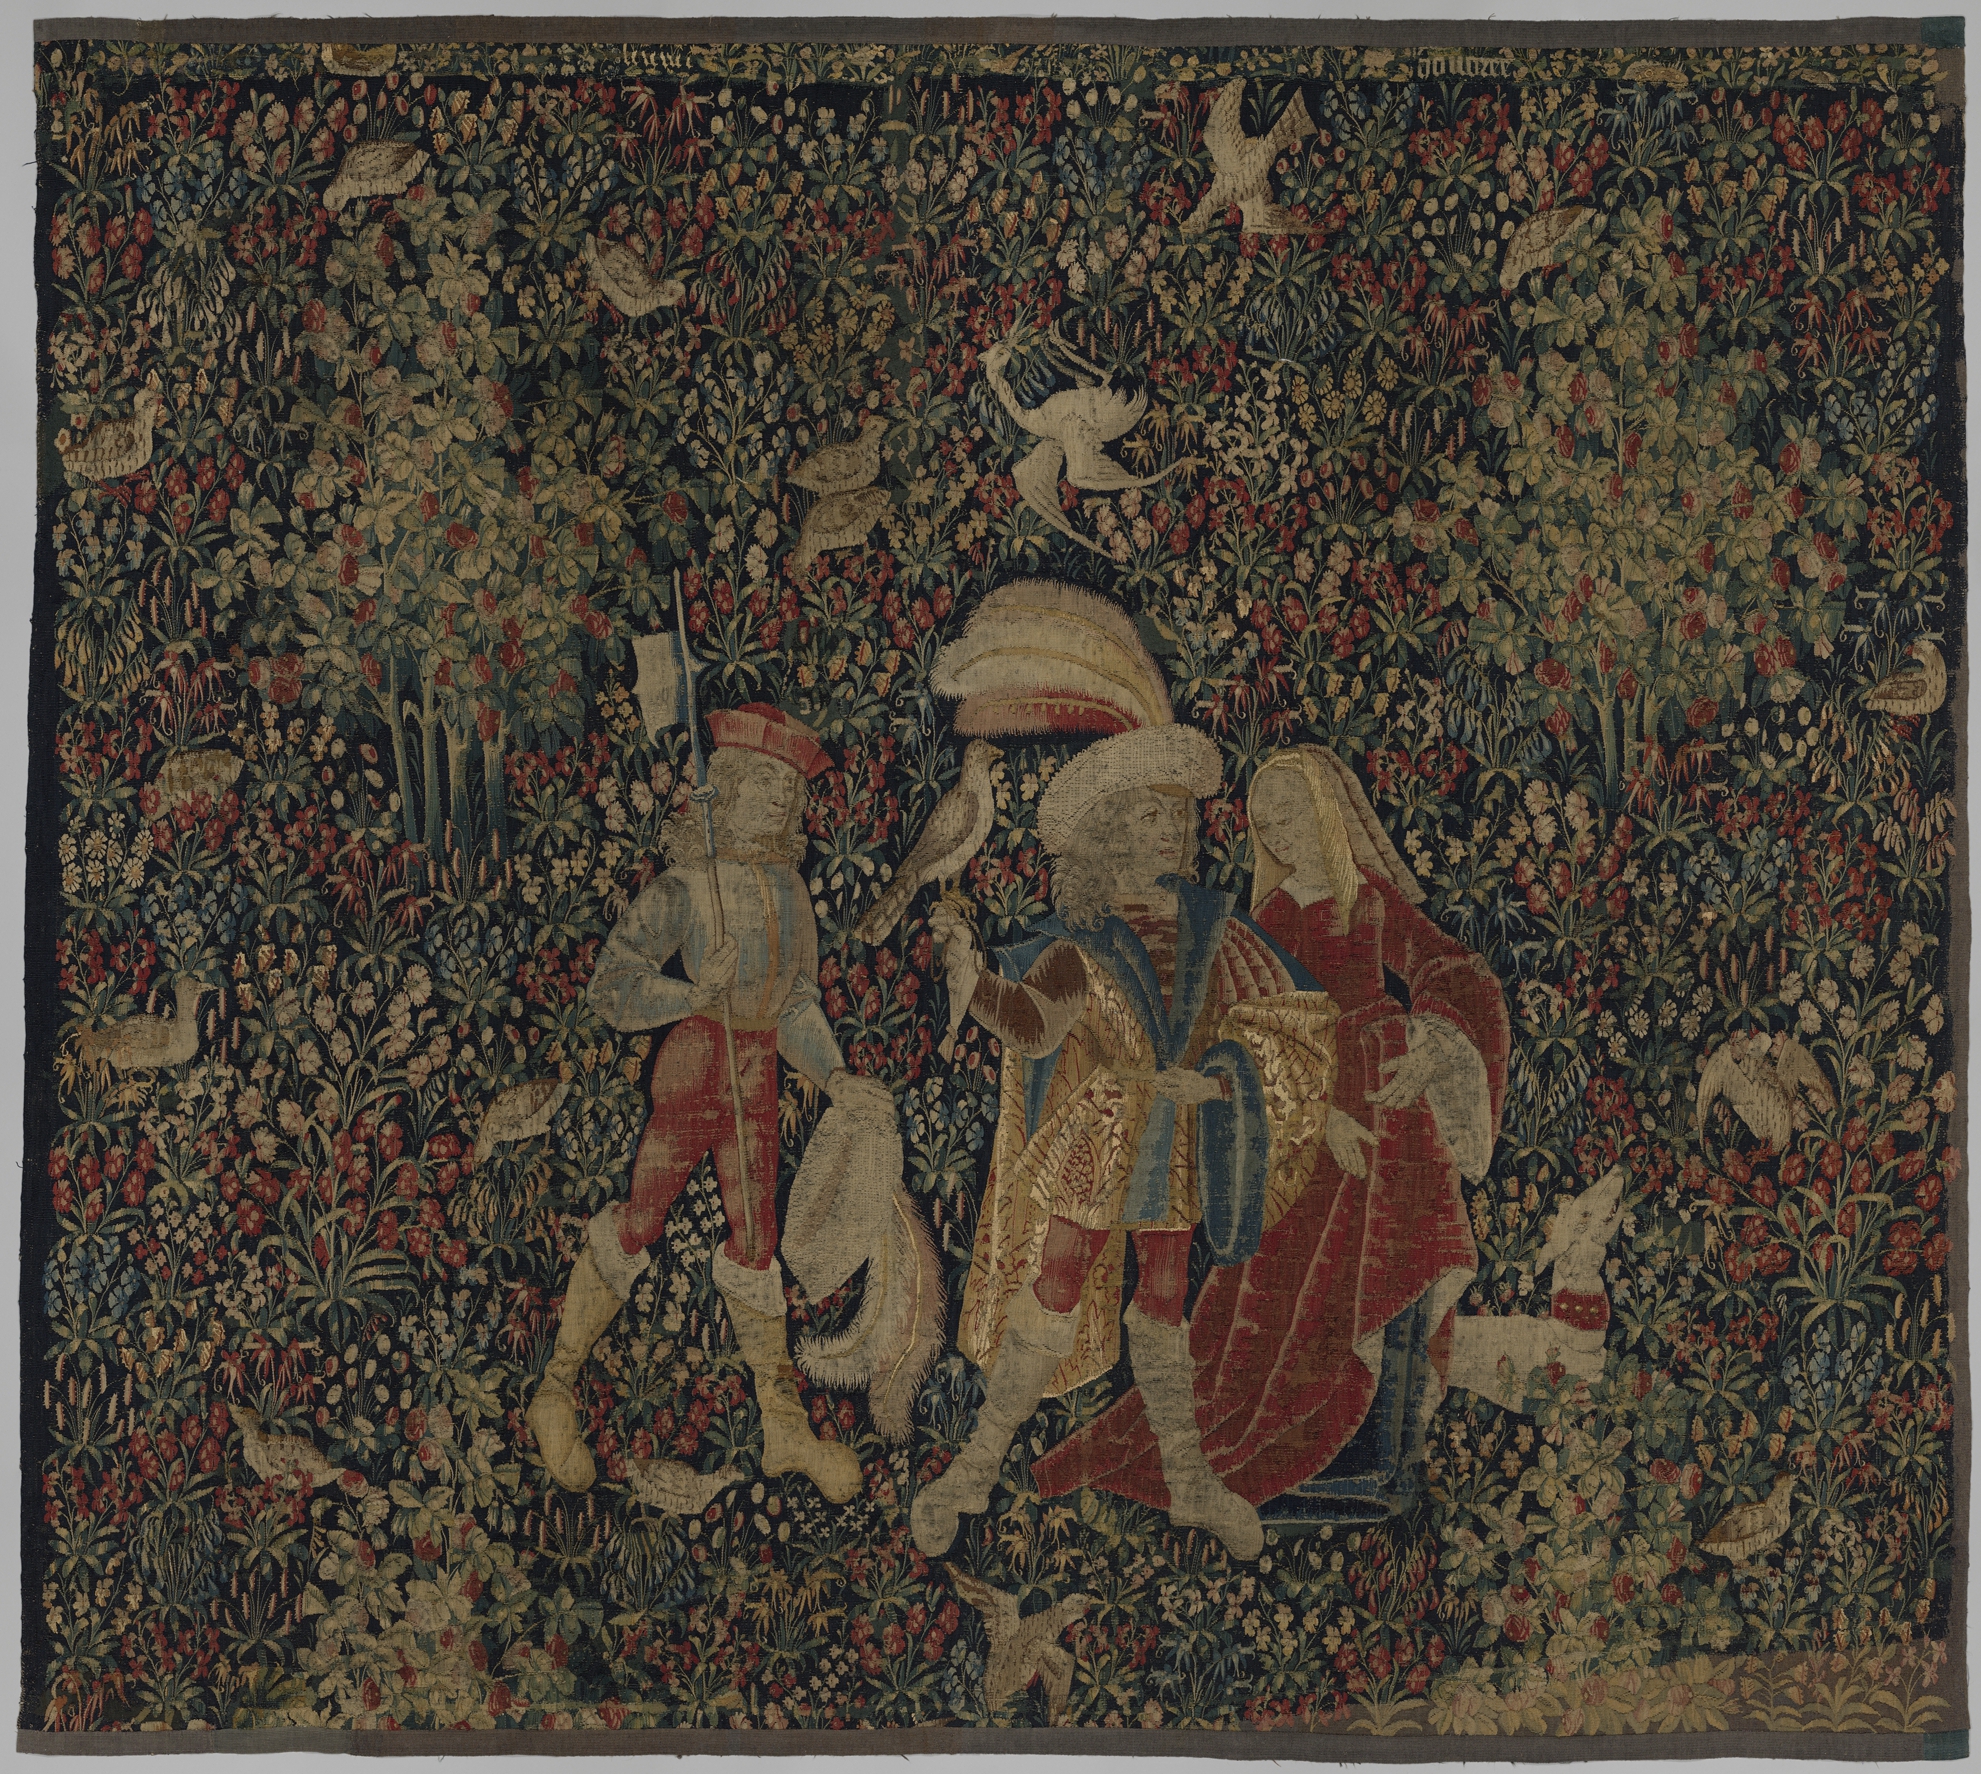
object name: hanging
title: The Falcon Hunt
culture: southern netherlands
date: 1500-1530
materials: silk, wool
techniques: tapestry weave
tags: birds,falcons,men,women,hunting,dogs,flowers